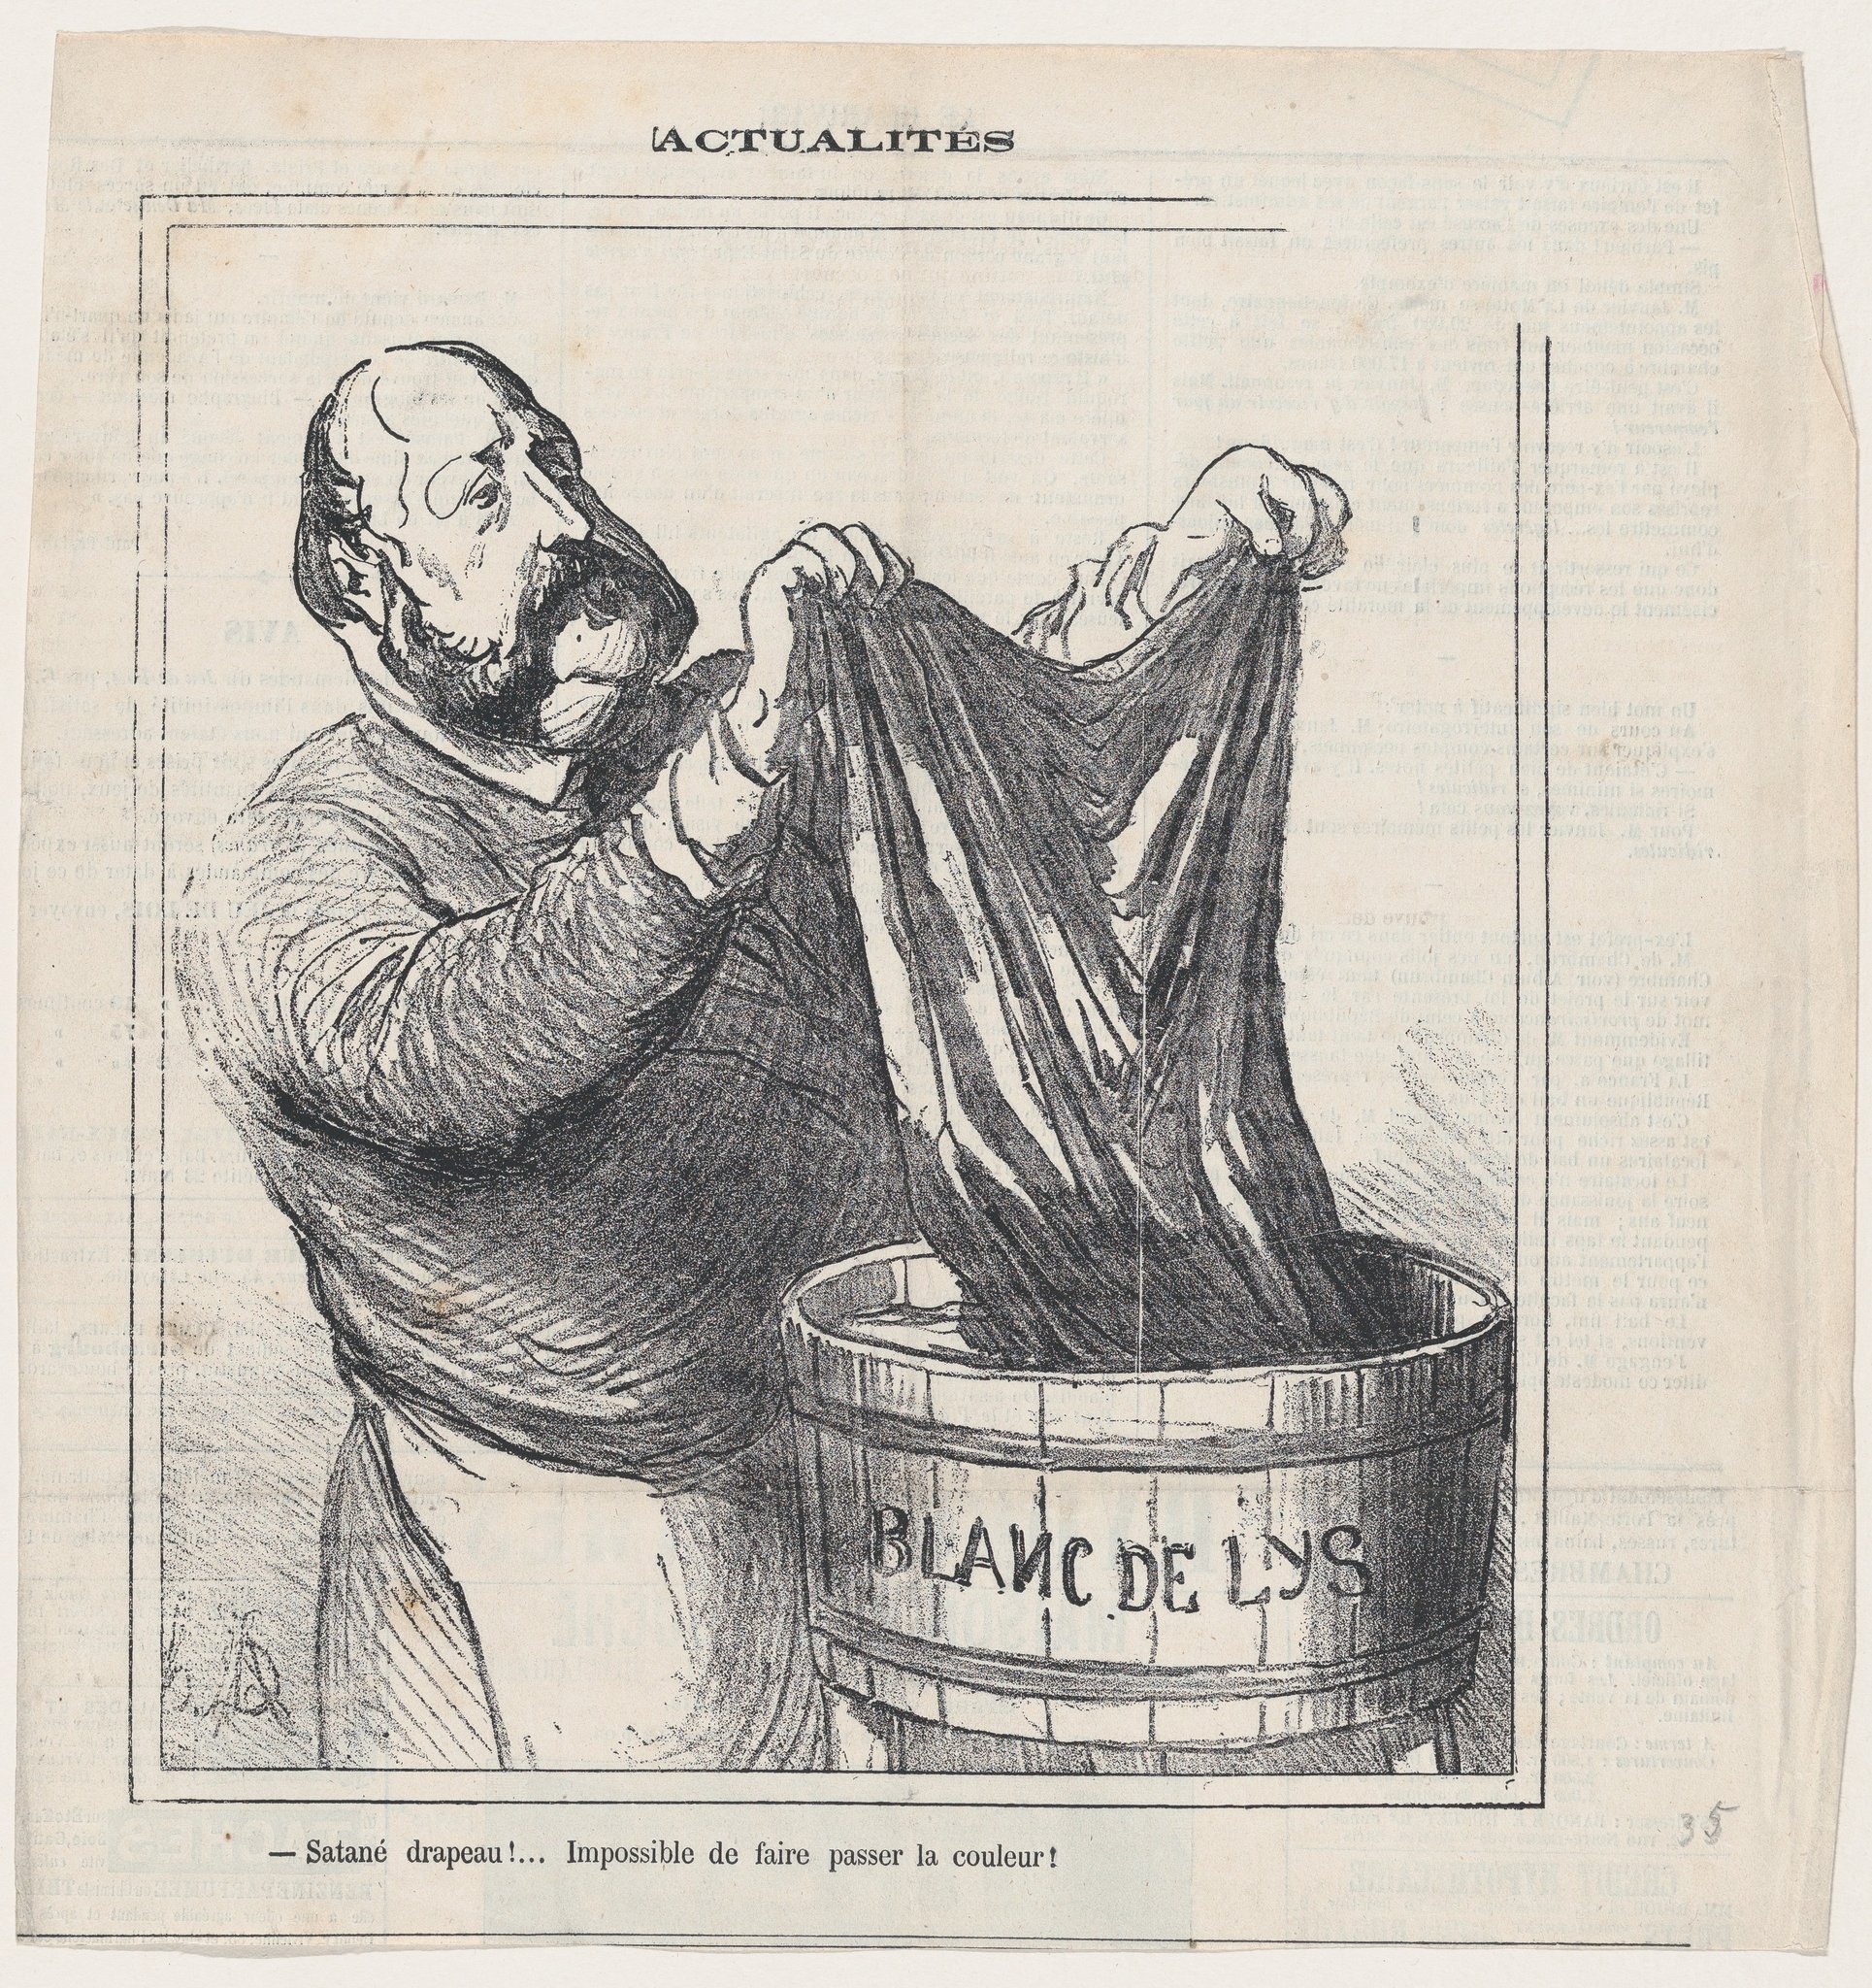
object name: print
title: Damned flag! Impossible to get rid of the color, from 'News of the day,' published in "Le Charivari"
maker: honoré daumier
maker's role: artist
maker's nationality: french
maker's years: 1808-1879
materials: paper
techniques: lithograph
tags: satire,men,working